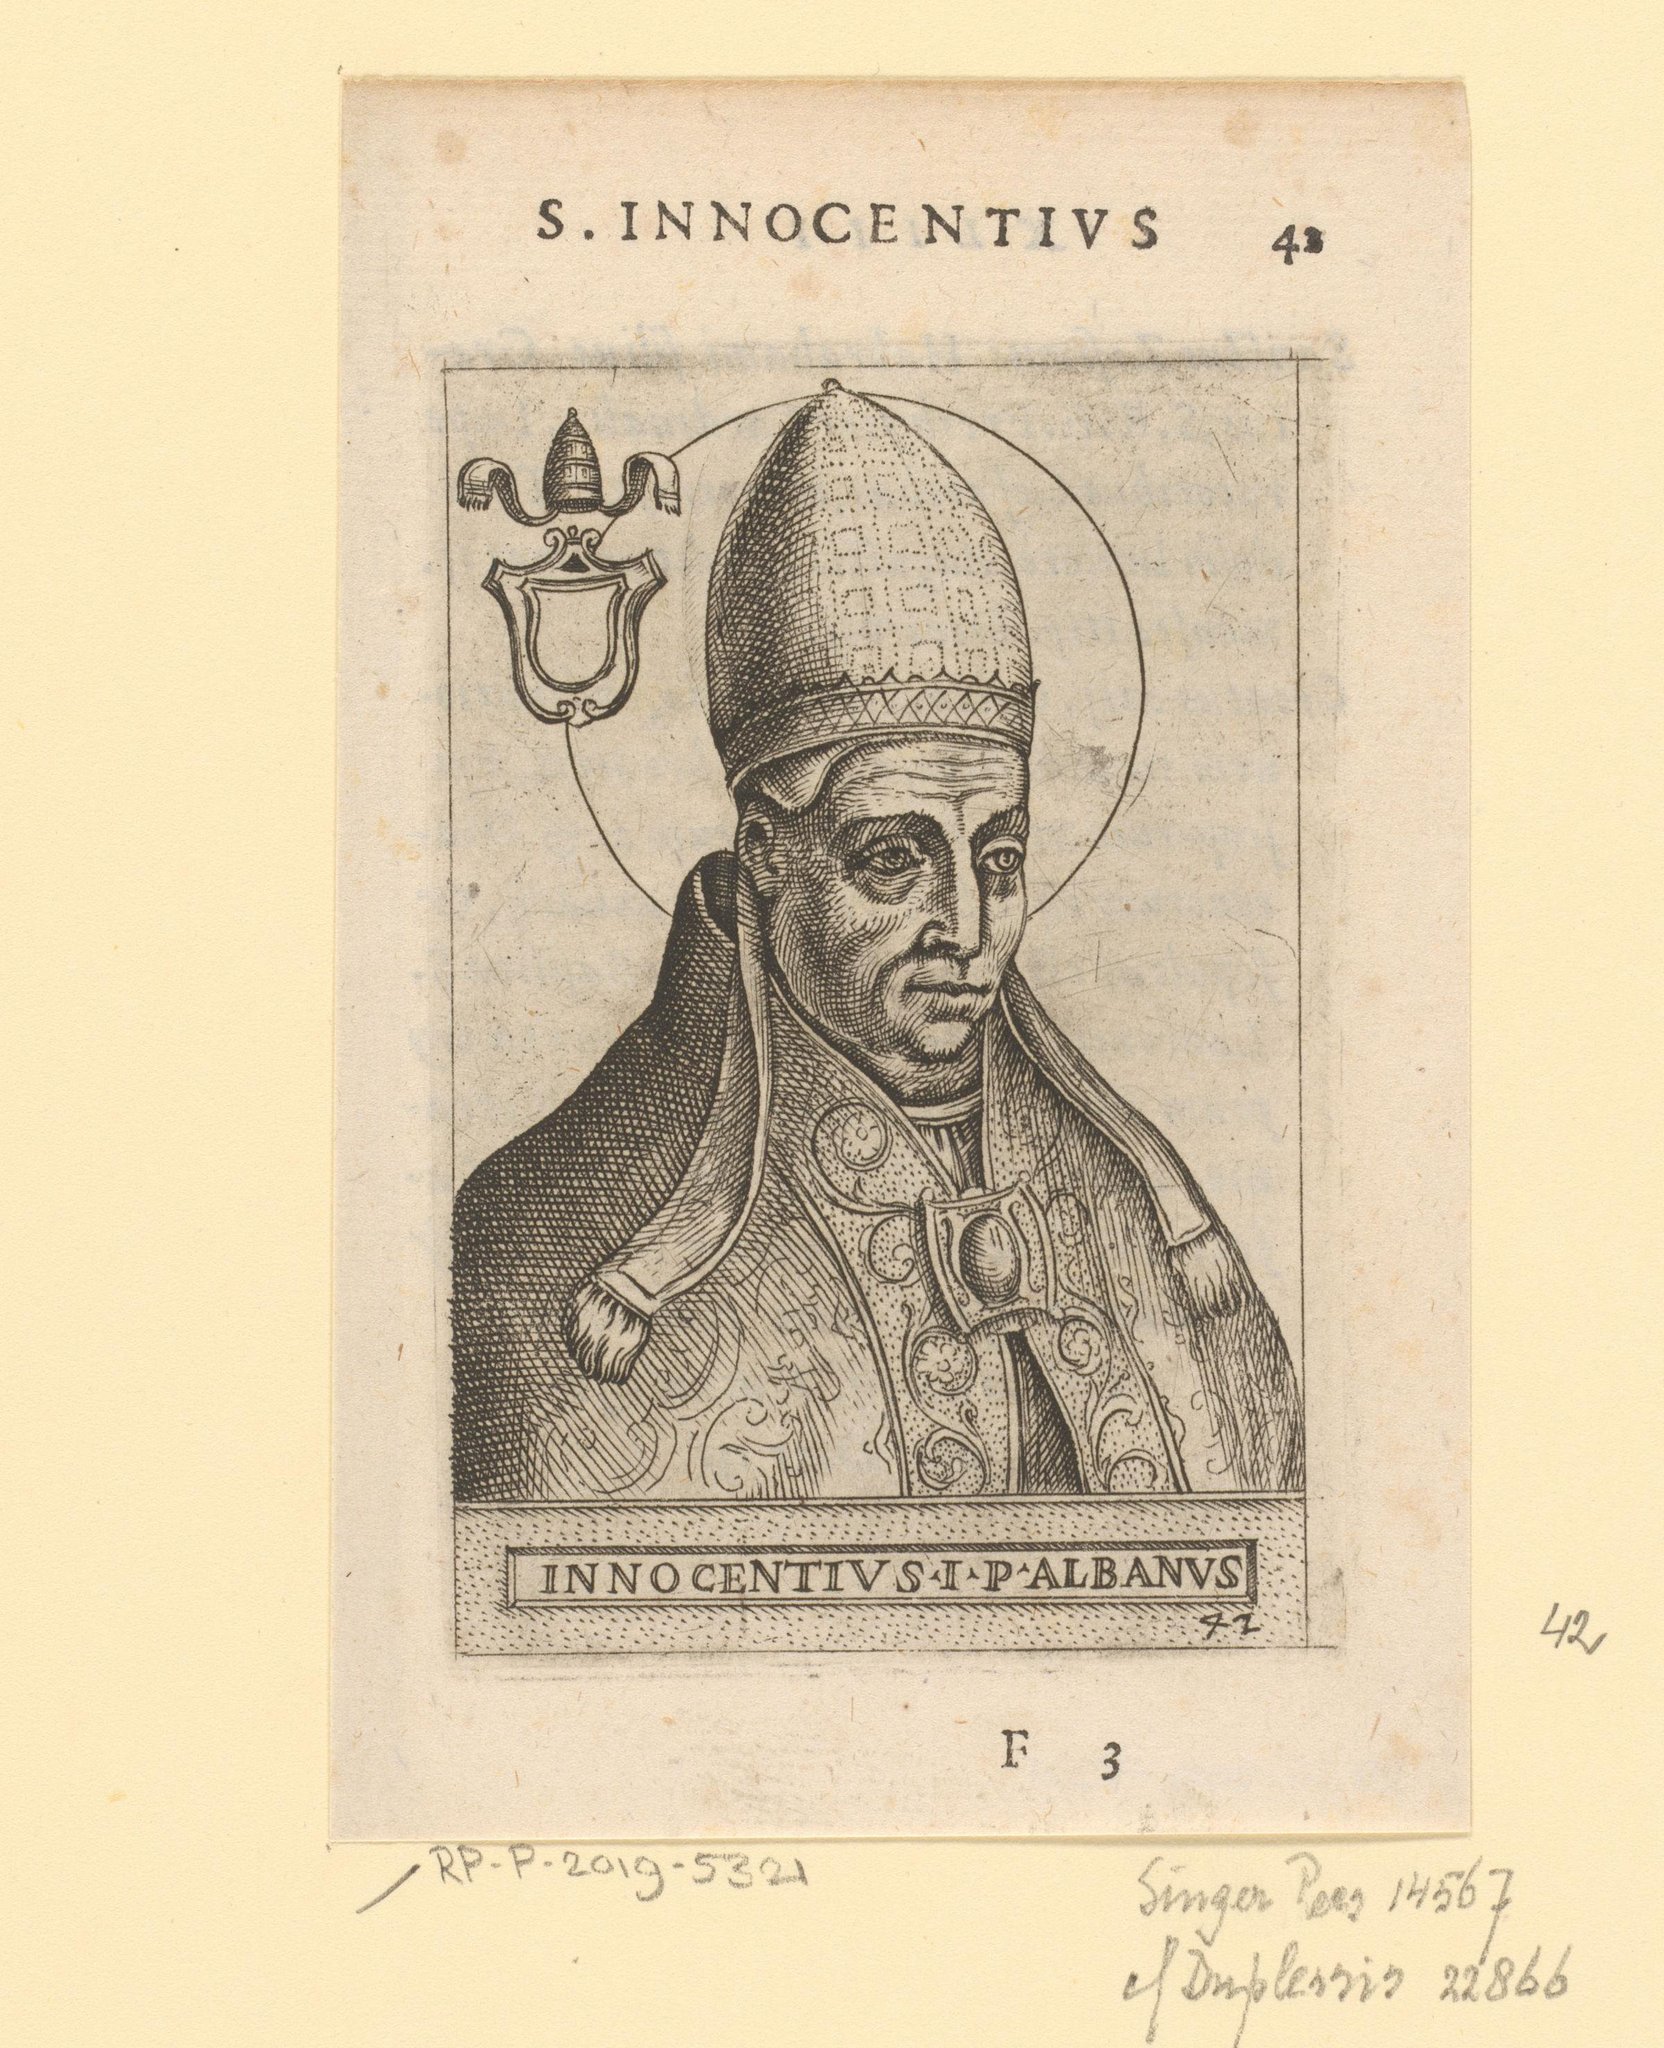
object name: print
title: Portret van paus Innocentius I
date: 1595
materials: paper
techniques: engraving, letterpress printing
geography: rome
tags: historical persons, pope, armorial bearing, heraldry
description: Prent uit: Cavalieri, Giovanni Battista de'. Effigies pontificum romanorum cum eorum vitis (...). Rome: Bartolomeo Bonfadino, 1595. Prent voor het eerst verschenen in: Cavalieri, Giovanni Battista de'. Pontificum romanorum effigies (...). Rome: Domenico Basa en Francesco Zanetti, 1580. Prent ook gebruikt in latere publicaties.